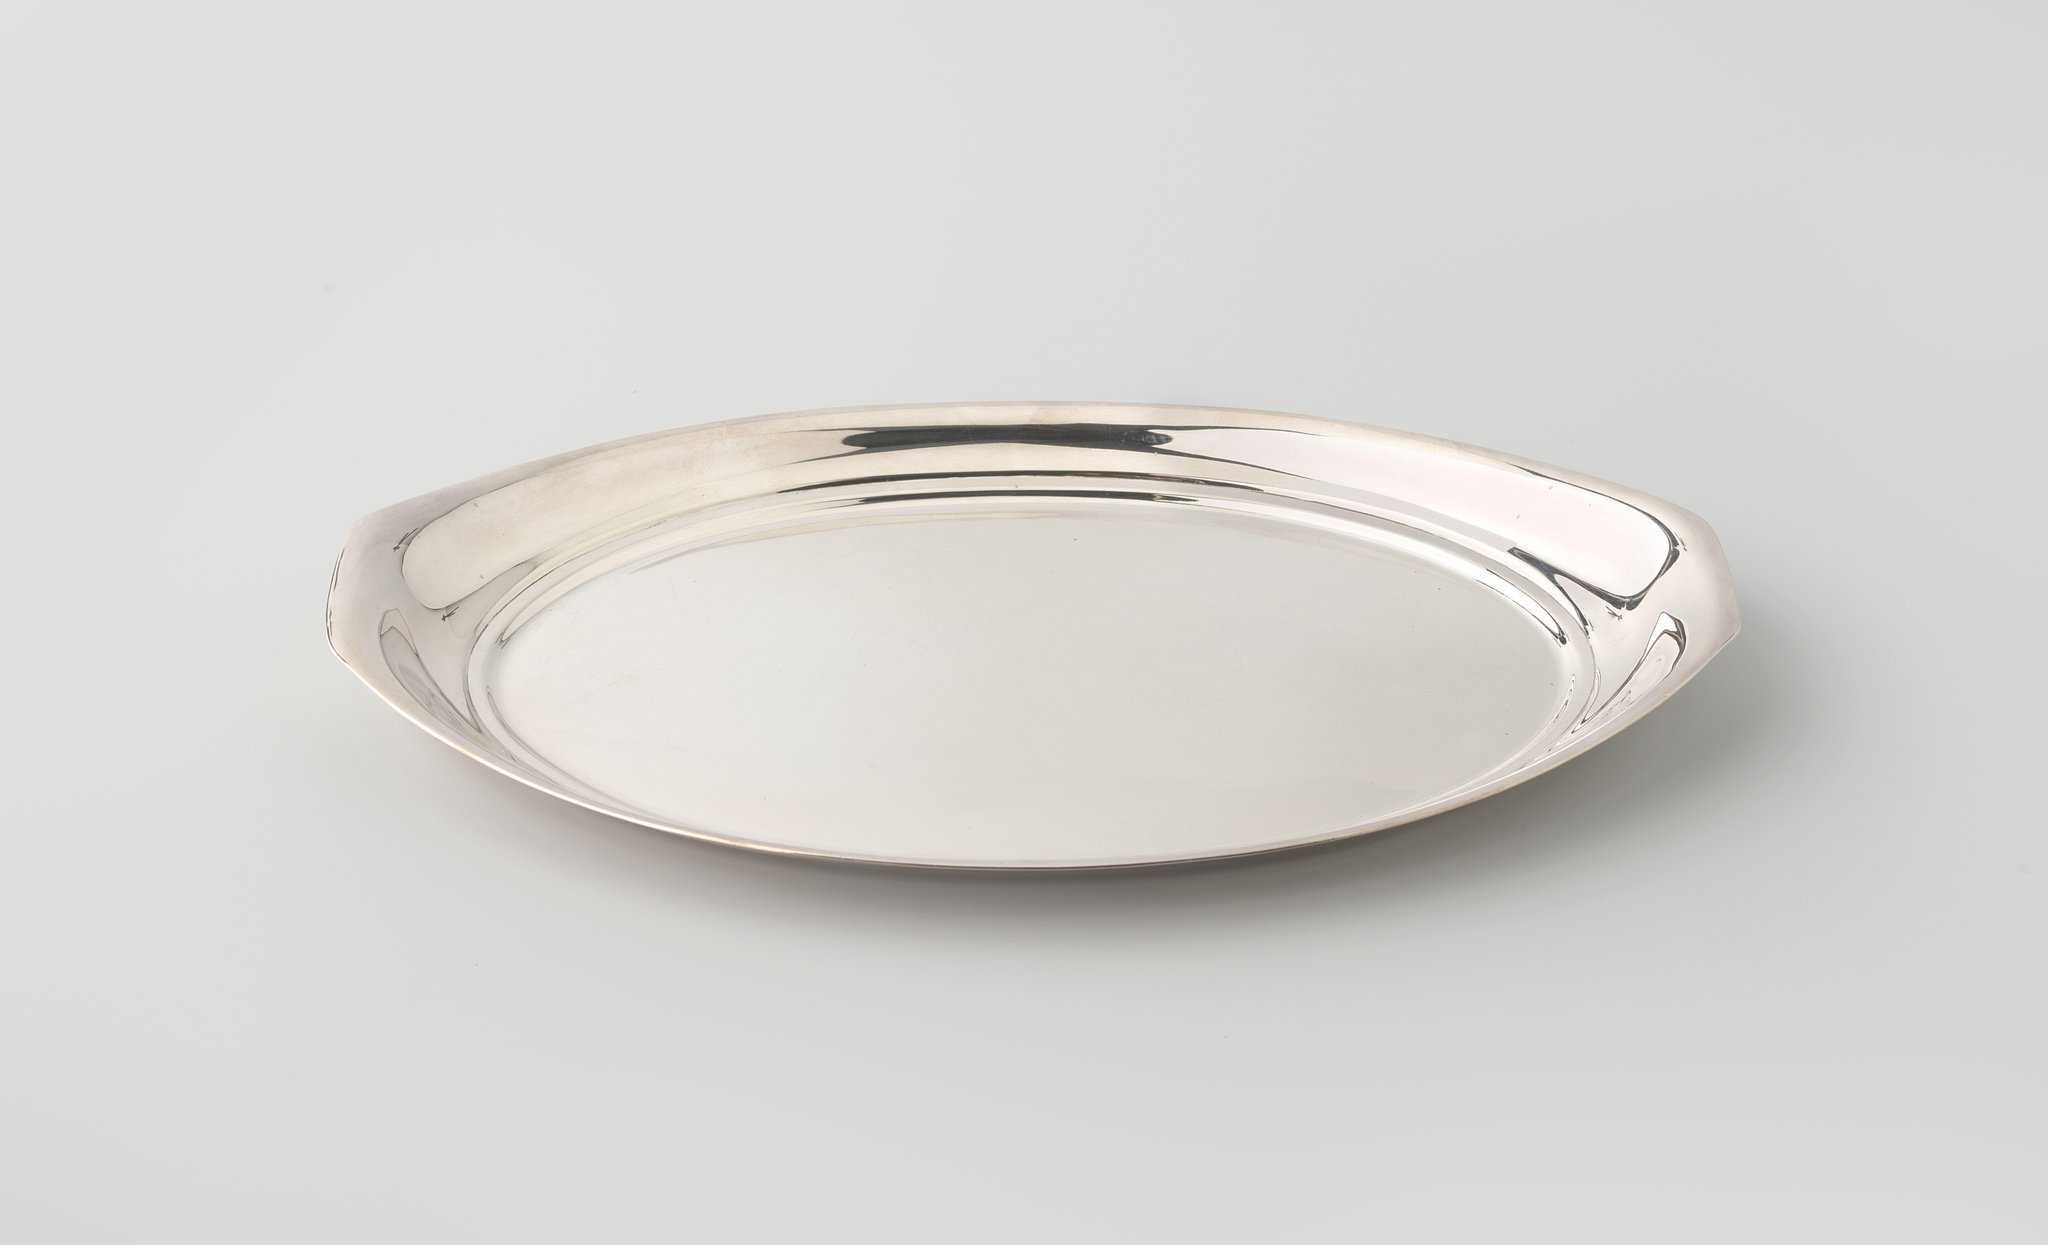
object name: blad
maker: gustav beran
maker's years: 1912-2006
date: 1967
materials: wood, silver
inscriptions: maker's mark: ‘VKB = N.V. Koninklijke Van Kempen & Begeer, Zeist-Voorschoten, jaarletter h = 1967’, mark: ‘Staande leeuw met 1 = 0.925 zilver, Minervakop met C = keurkamer Den Haag’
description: Blad behorende bij een vierdelig mokkaservies. Het ovale blad heeft een achtkantige, gewelfde rand.